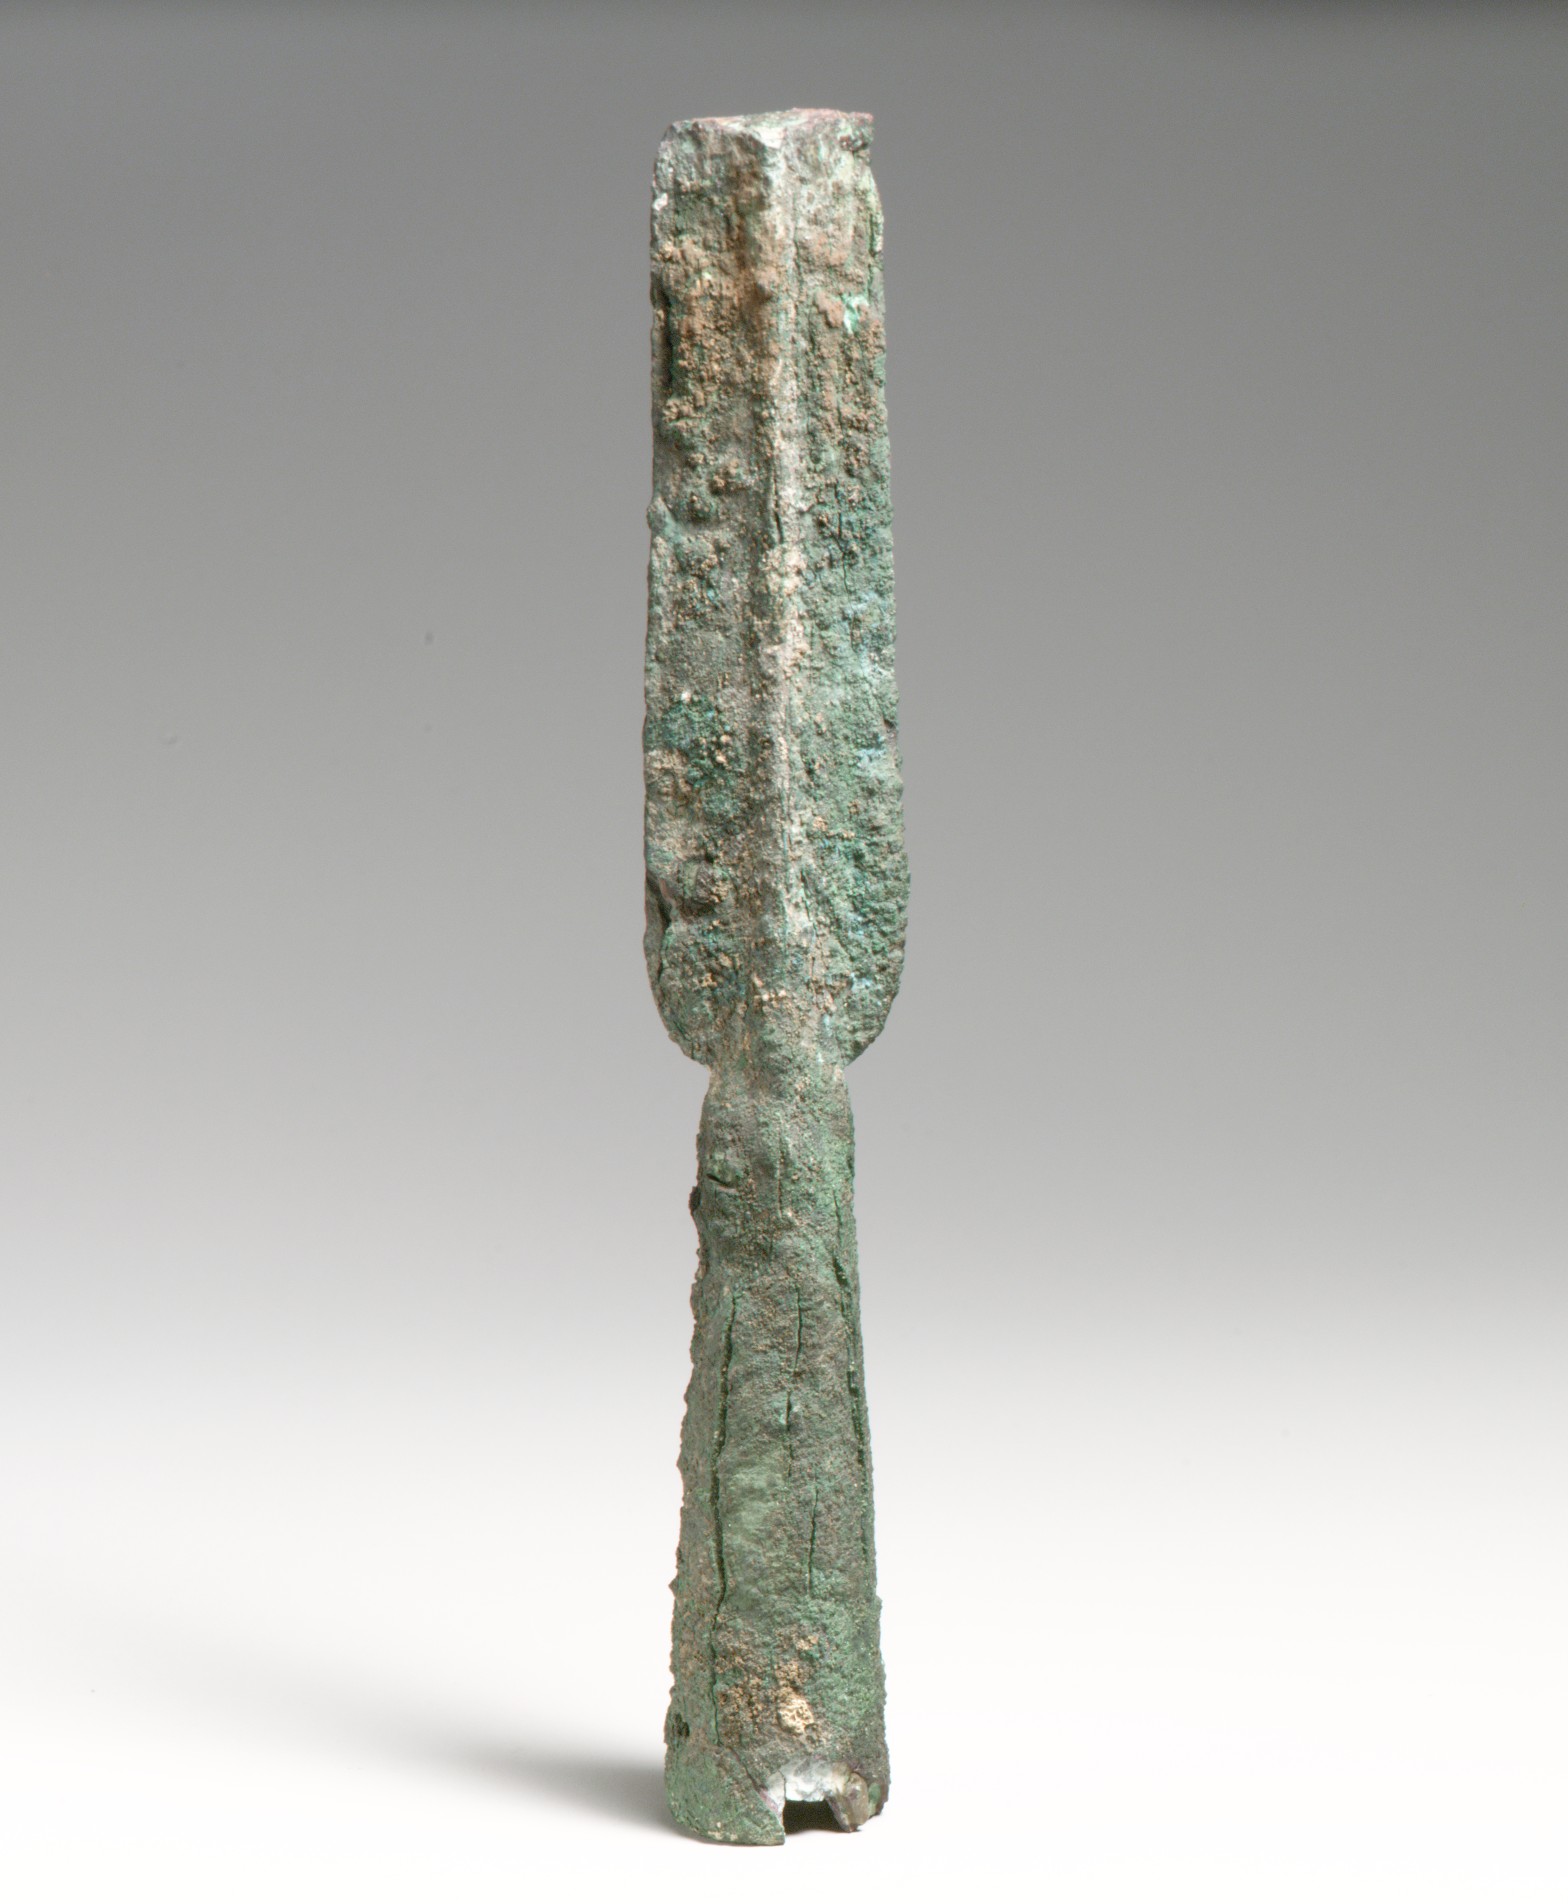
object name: spearhead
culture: cypriot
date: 1600-1050 BCE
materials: bronze